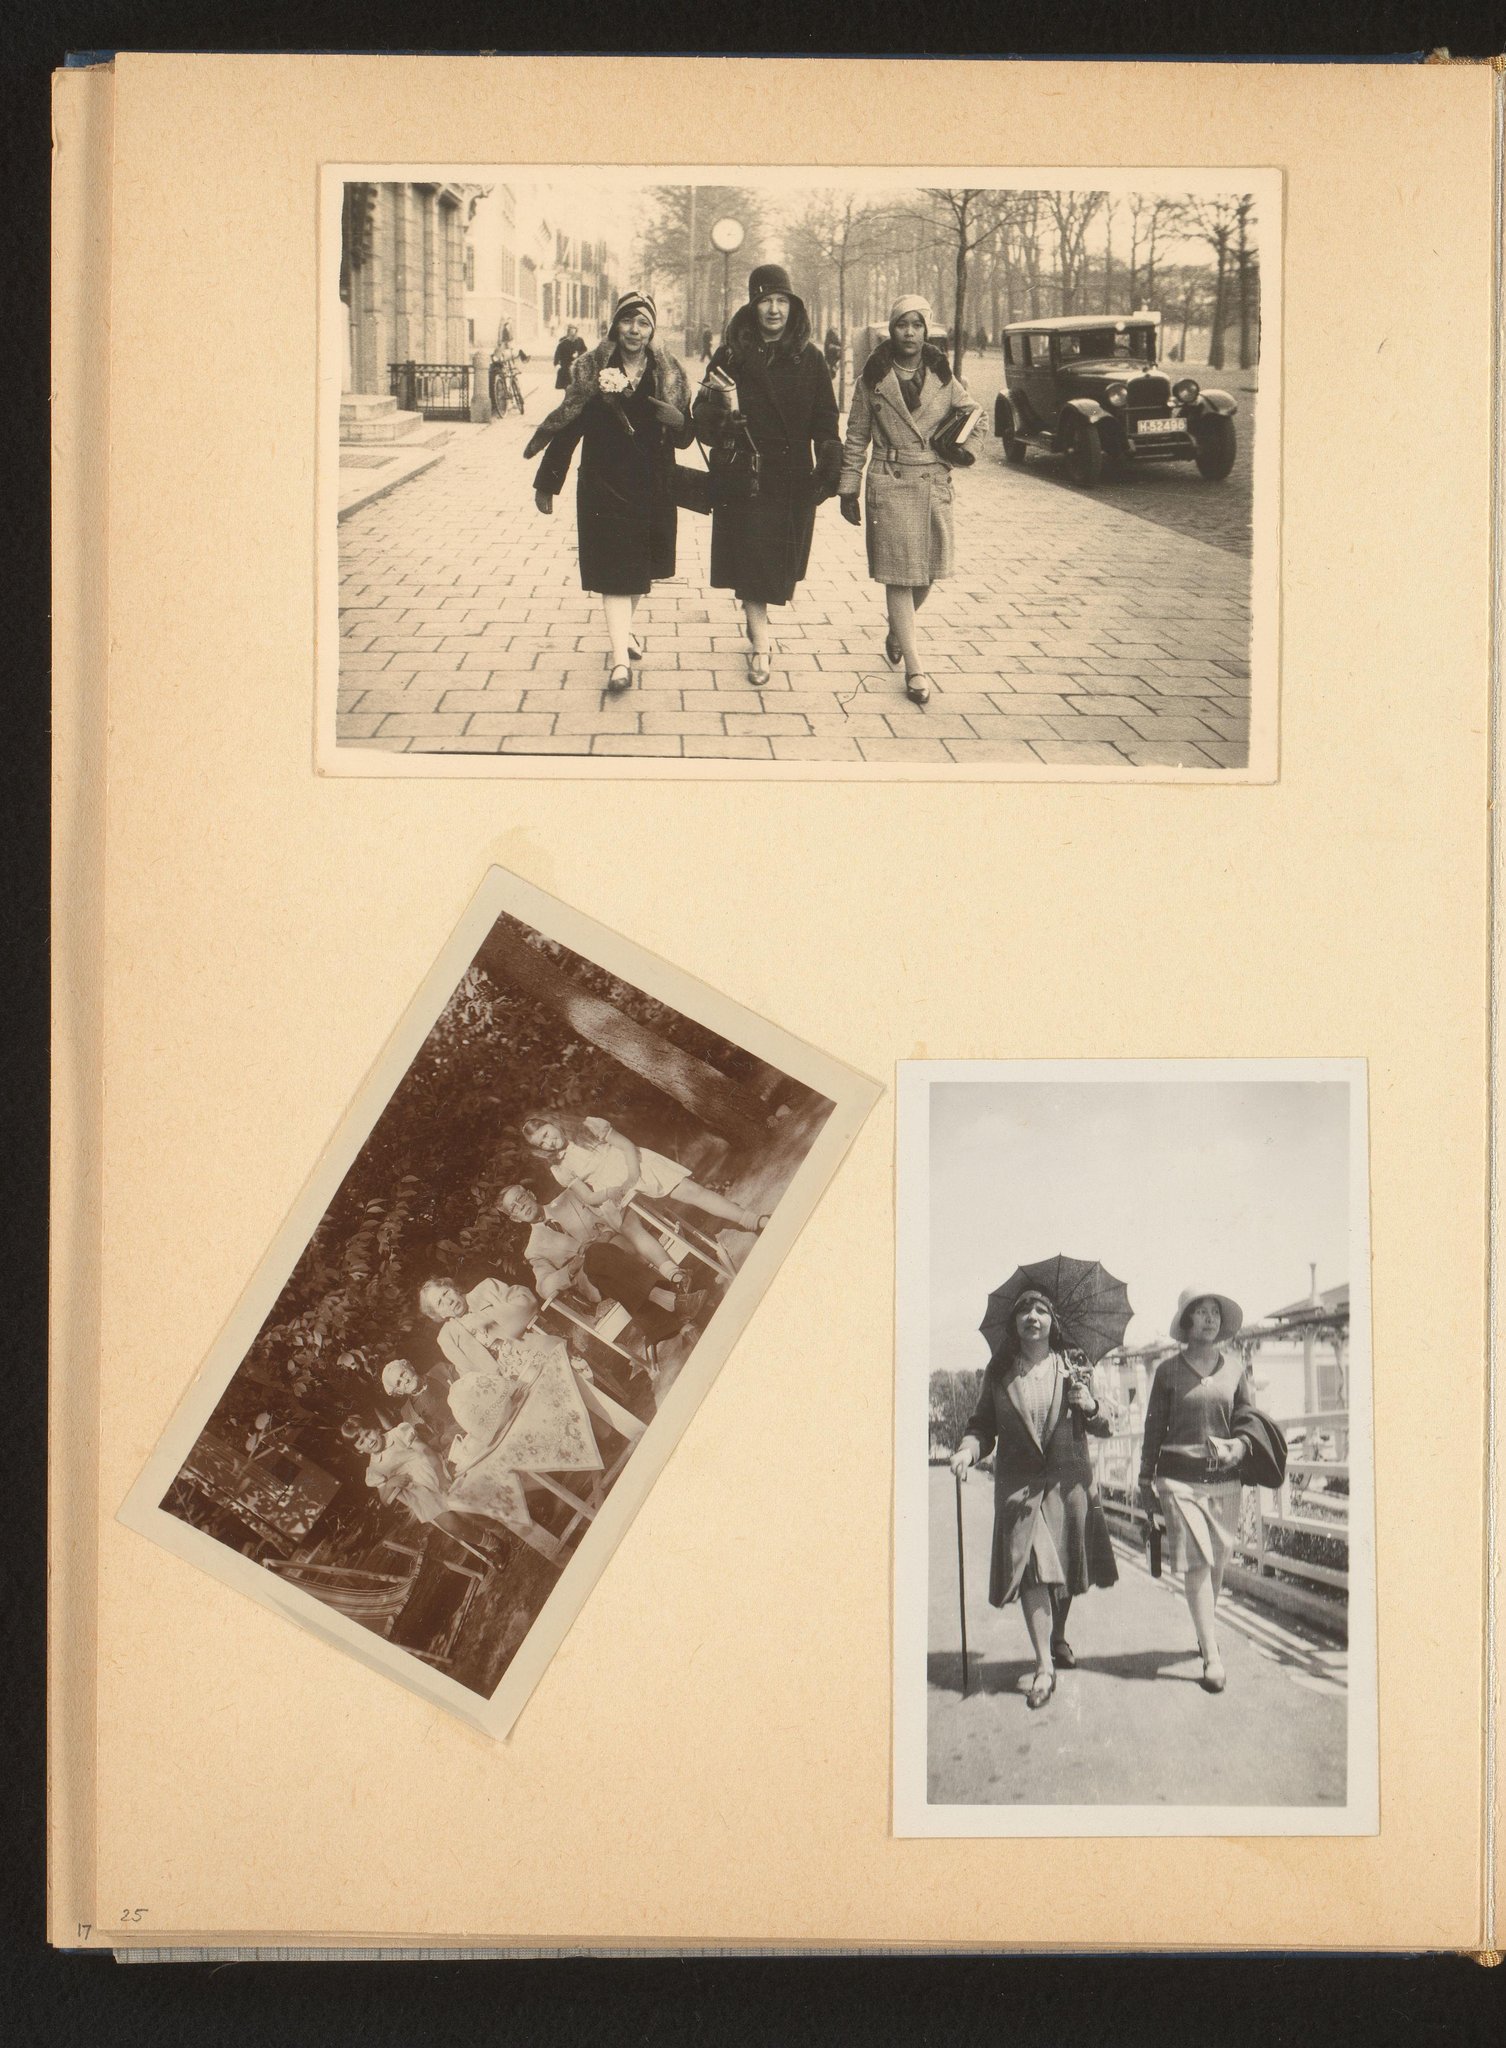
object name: album leaf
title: Eef Dumas met haar moeder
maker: frédéric gabriël dumas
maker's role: engineer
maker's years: 1886-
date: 1935-1940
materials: cardboard, photographic support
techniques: gelatin silver print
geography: netherlands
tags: paris, beatrice jacqueline eveline dumas, java, historical persons - bb - woman, netherlands, dutch east indies, the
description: Blad met drie foto's, twee van Eef Dumas op straat met haar moeder, de derde van een onbekende familie in de tuin. Onderdeel van het fotoalbum van Beatrice Jacqueline Eveline (Eef) Dumas, ca. 1880-1952.